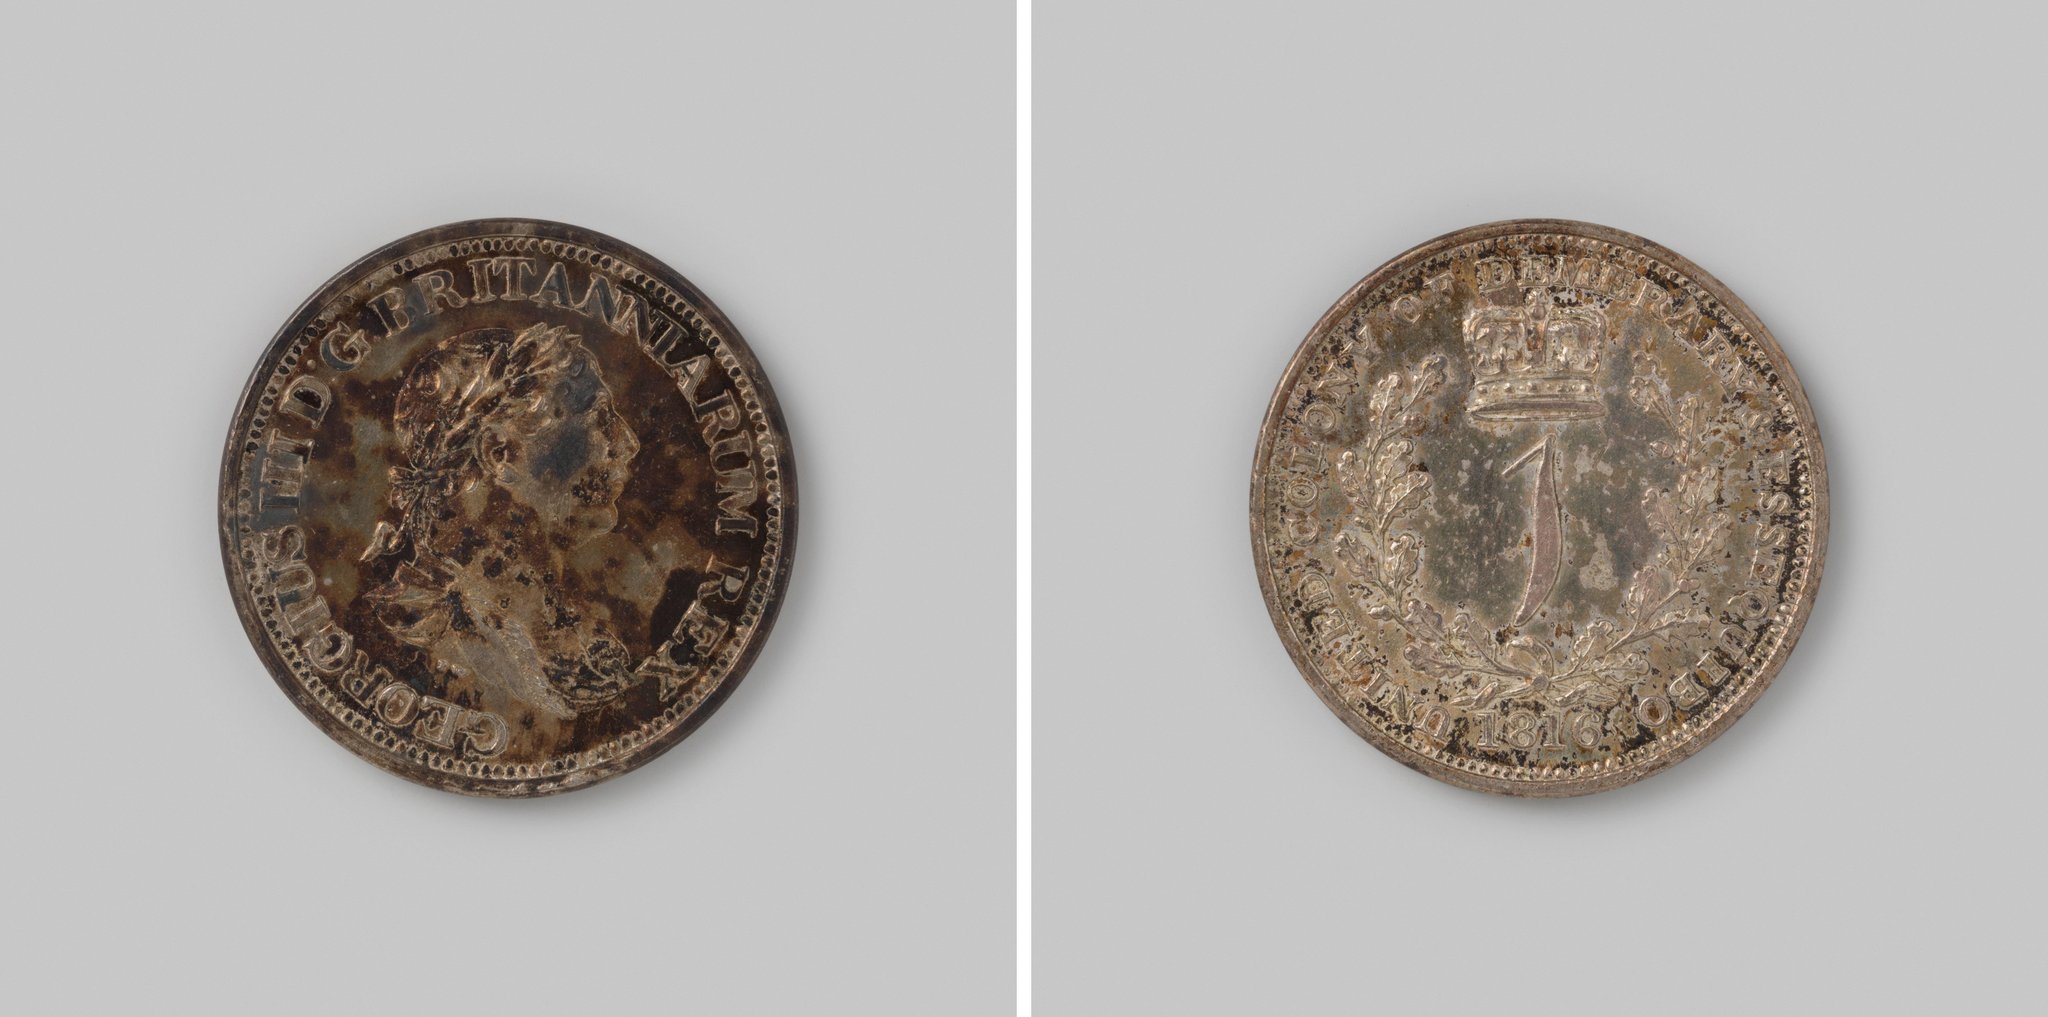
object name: coin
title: Essequibo & Demarary, koning George III, guilder, 1816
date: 1816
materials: silver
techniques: striking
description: Zilveren munt. Voorzijde: gelauwerd borstbeeld van de koning naar rechts. Keerzijde: tussen twee samengebonden takken waarde-aanduiding: 1, waarboven kroon. Jaartal onderaan in omschrift. Gladde rand.